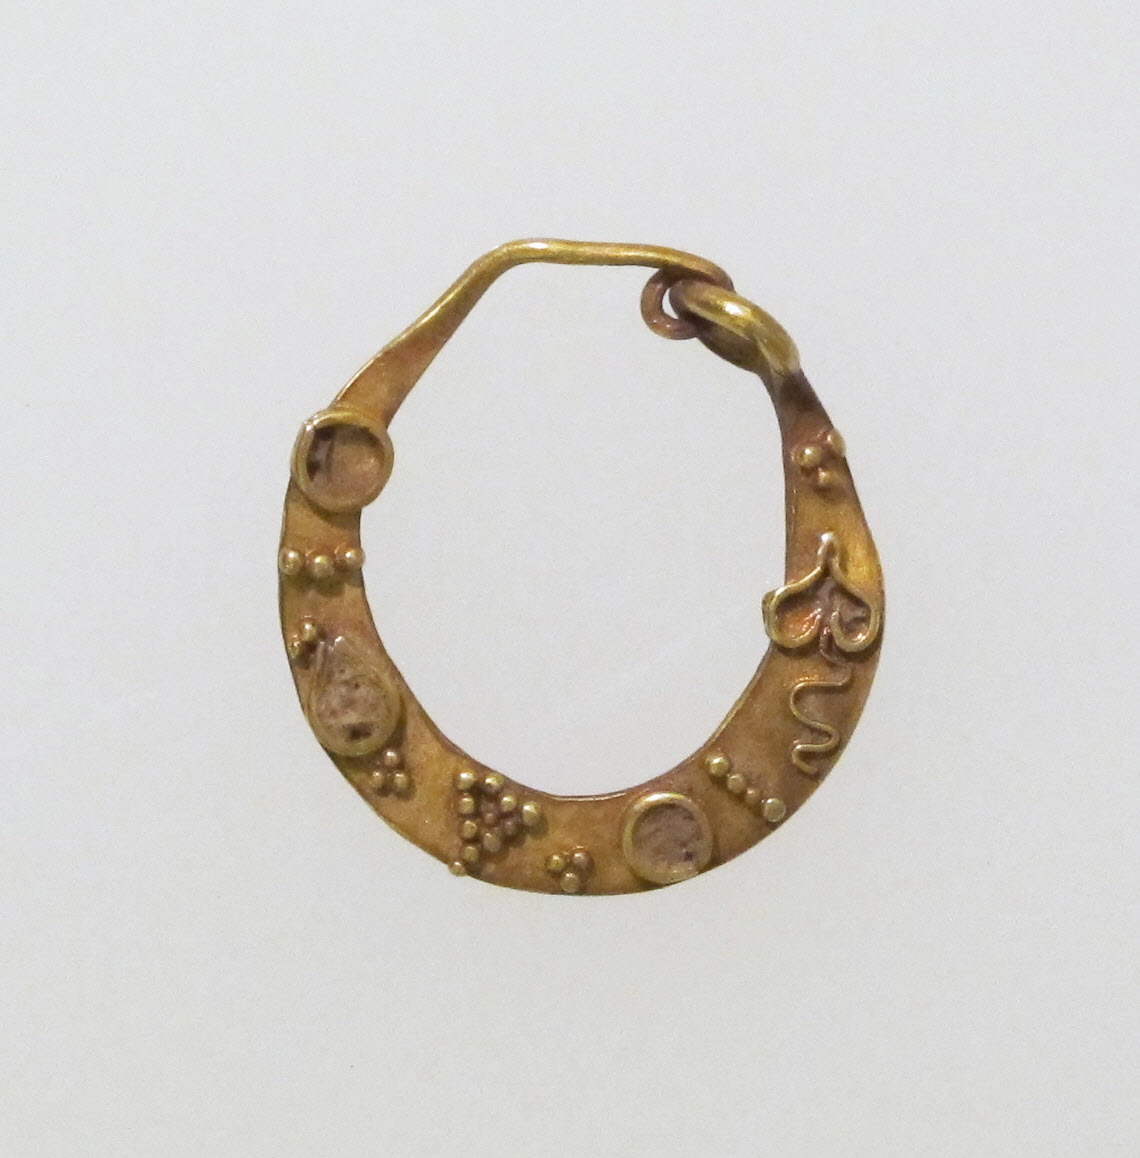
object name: earring, crescent shaped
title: Earring, crescent-shaped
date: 7000 BCE-330 CE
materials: gold